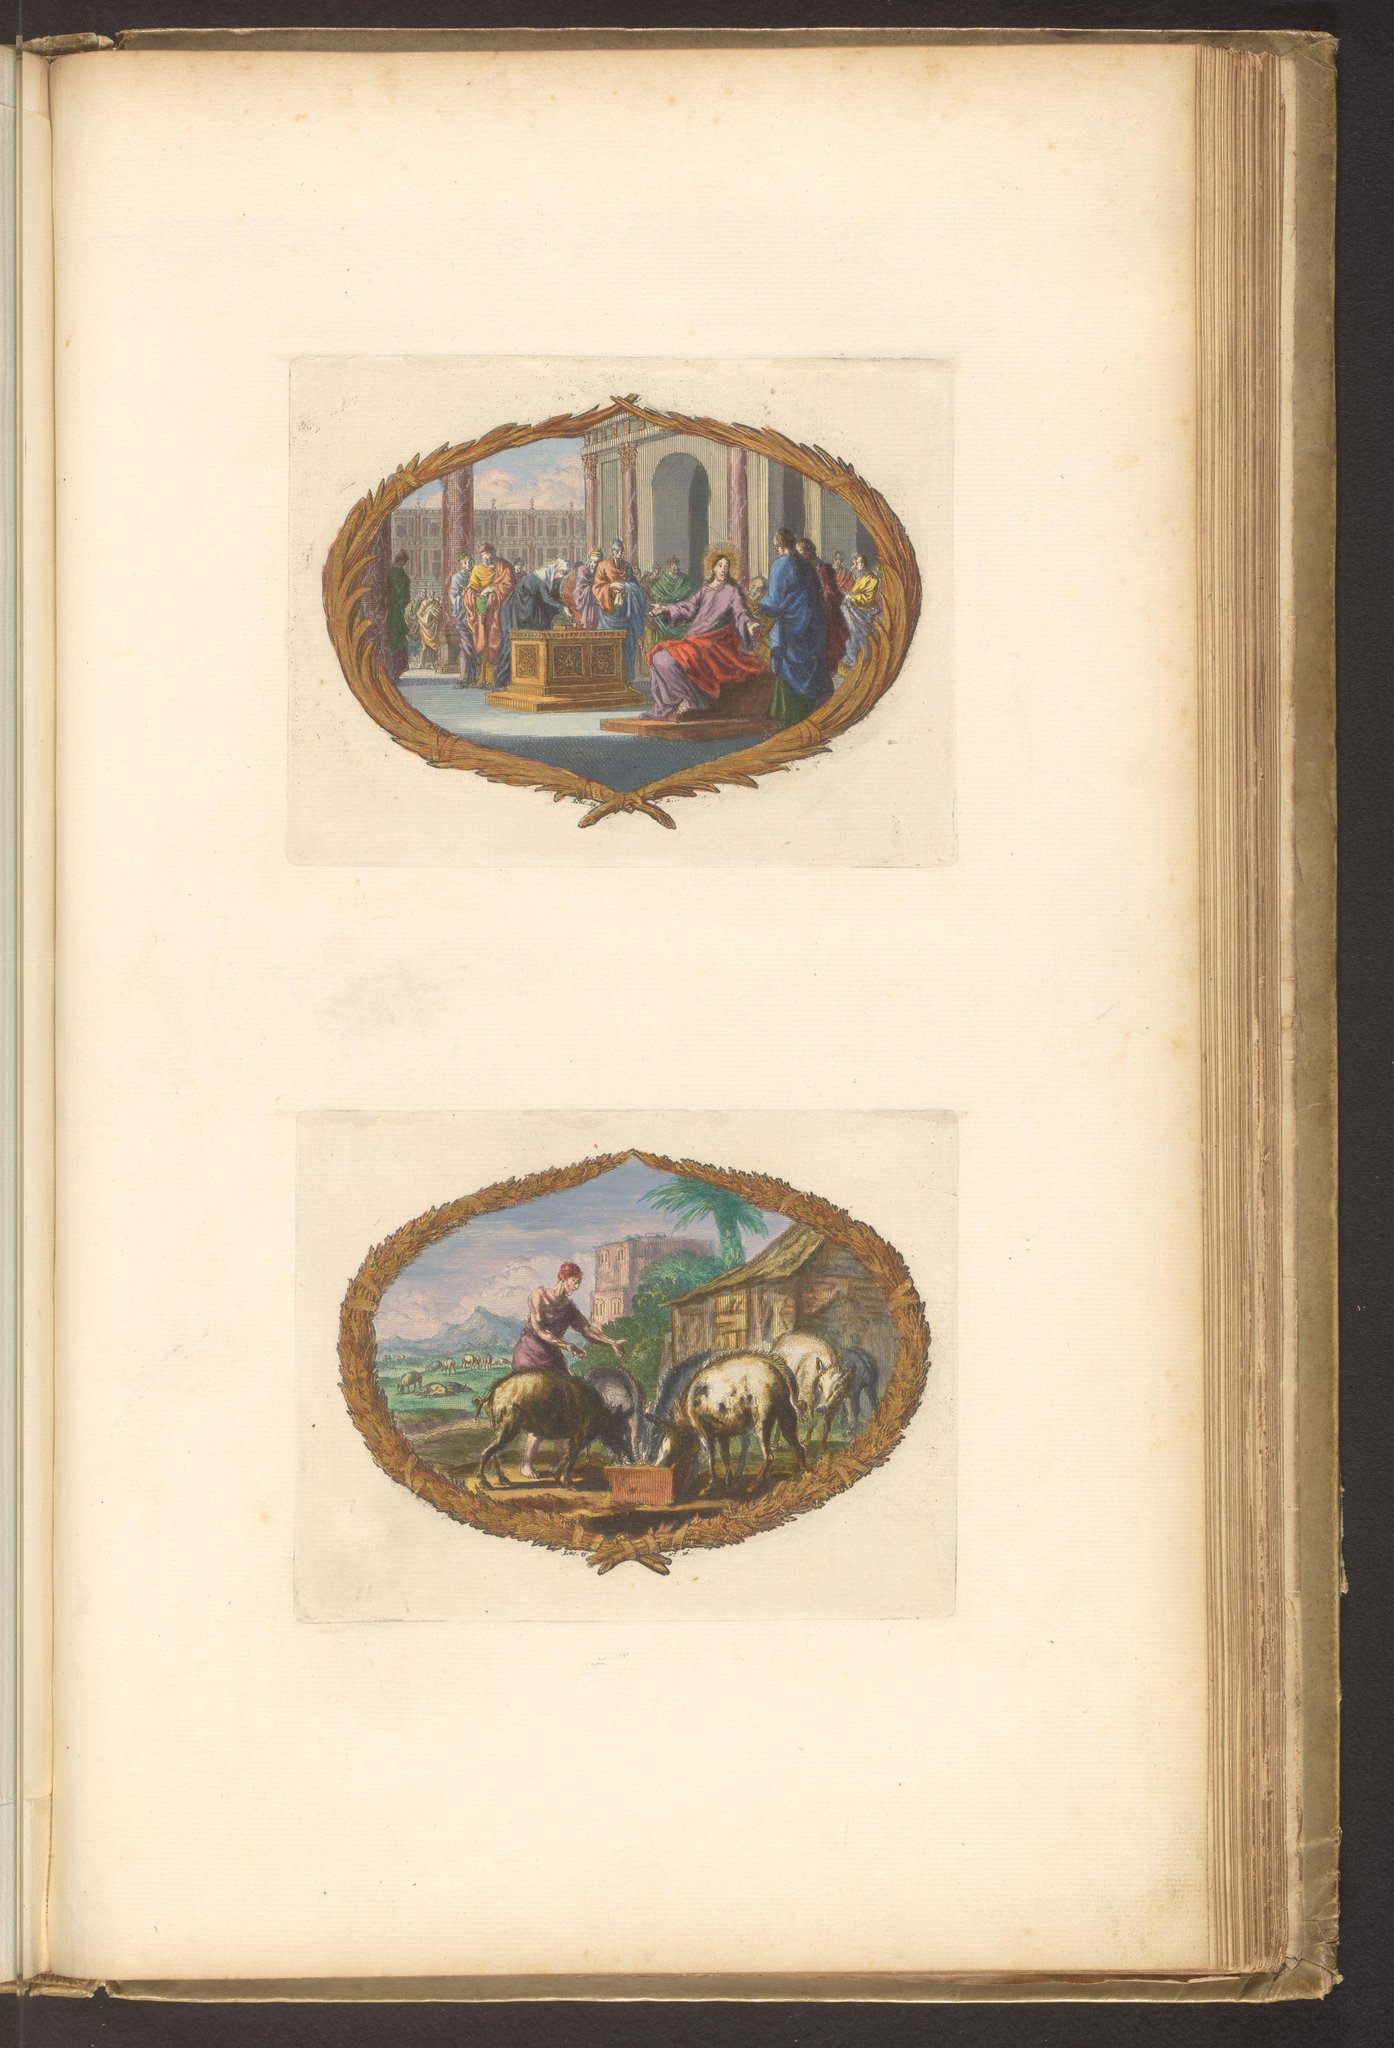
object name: print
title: Blad met twee vignetten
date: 1700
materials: paint, paper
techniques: etching, hand coloring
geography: amsterdam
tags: the widow's mite: christ draws the disciples' attention to a woman who puts a few coins in the temple's money chest (mark 12:41-44; luke 21:1-4), the prodigal son tends the swine and eats from their trough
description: Blad met twee vignetten tussen palmtakken. Boven: Vrijgevigheid van de arme weduwe. Christus wijst zijn leerlingen op een arme weduwe die wat geld in de offerkist werpt. Onder: De verloren zoon als varkenshoeder. Blad in het tweede deel van de prentbijbel met het Nieuwe Testament, uitgegeven door Pieter Mortier, Amsterdam 1700.